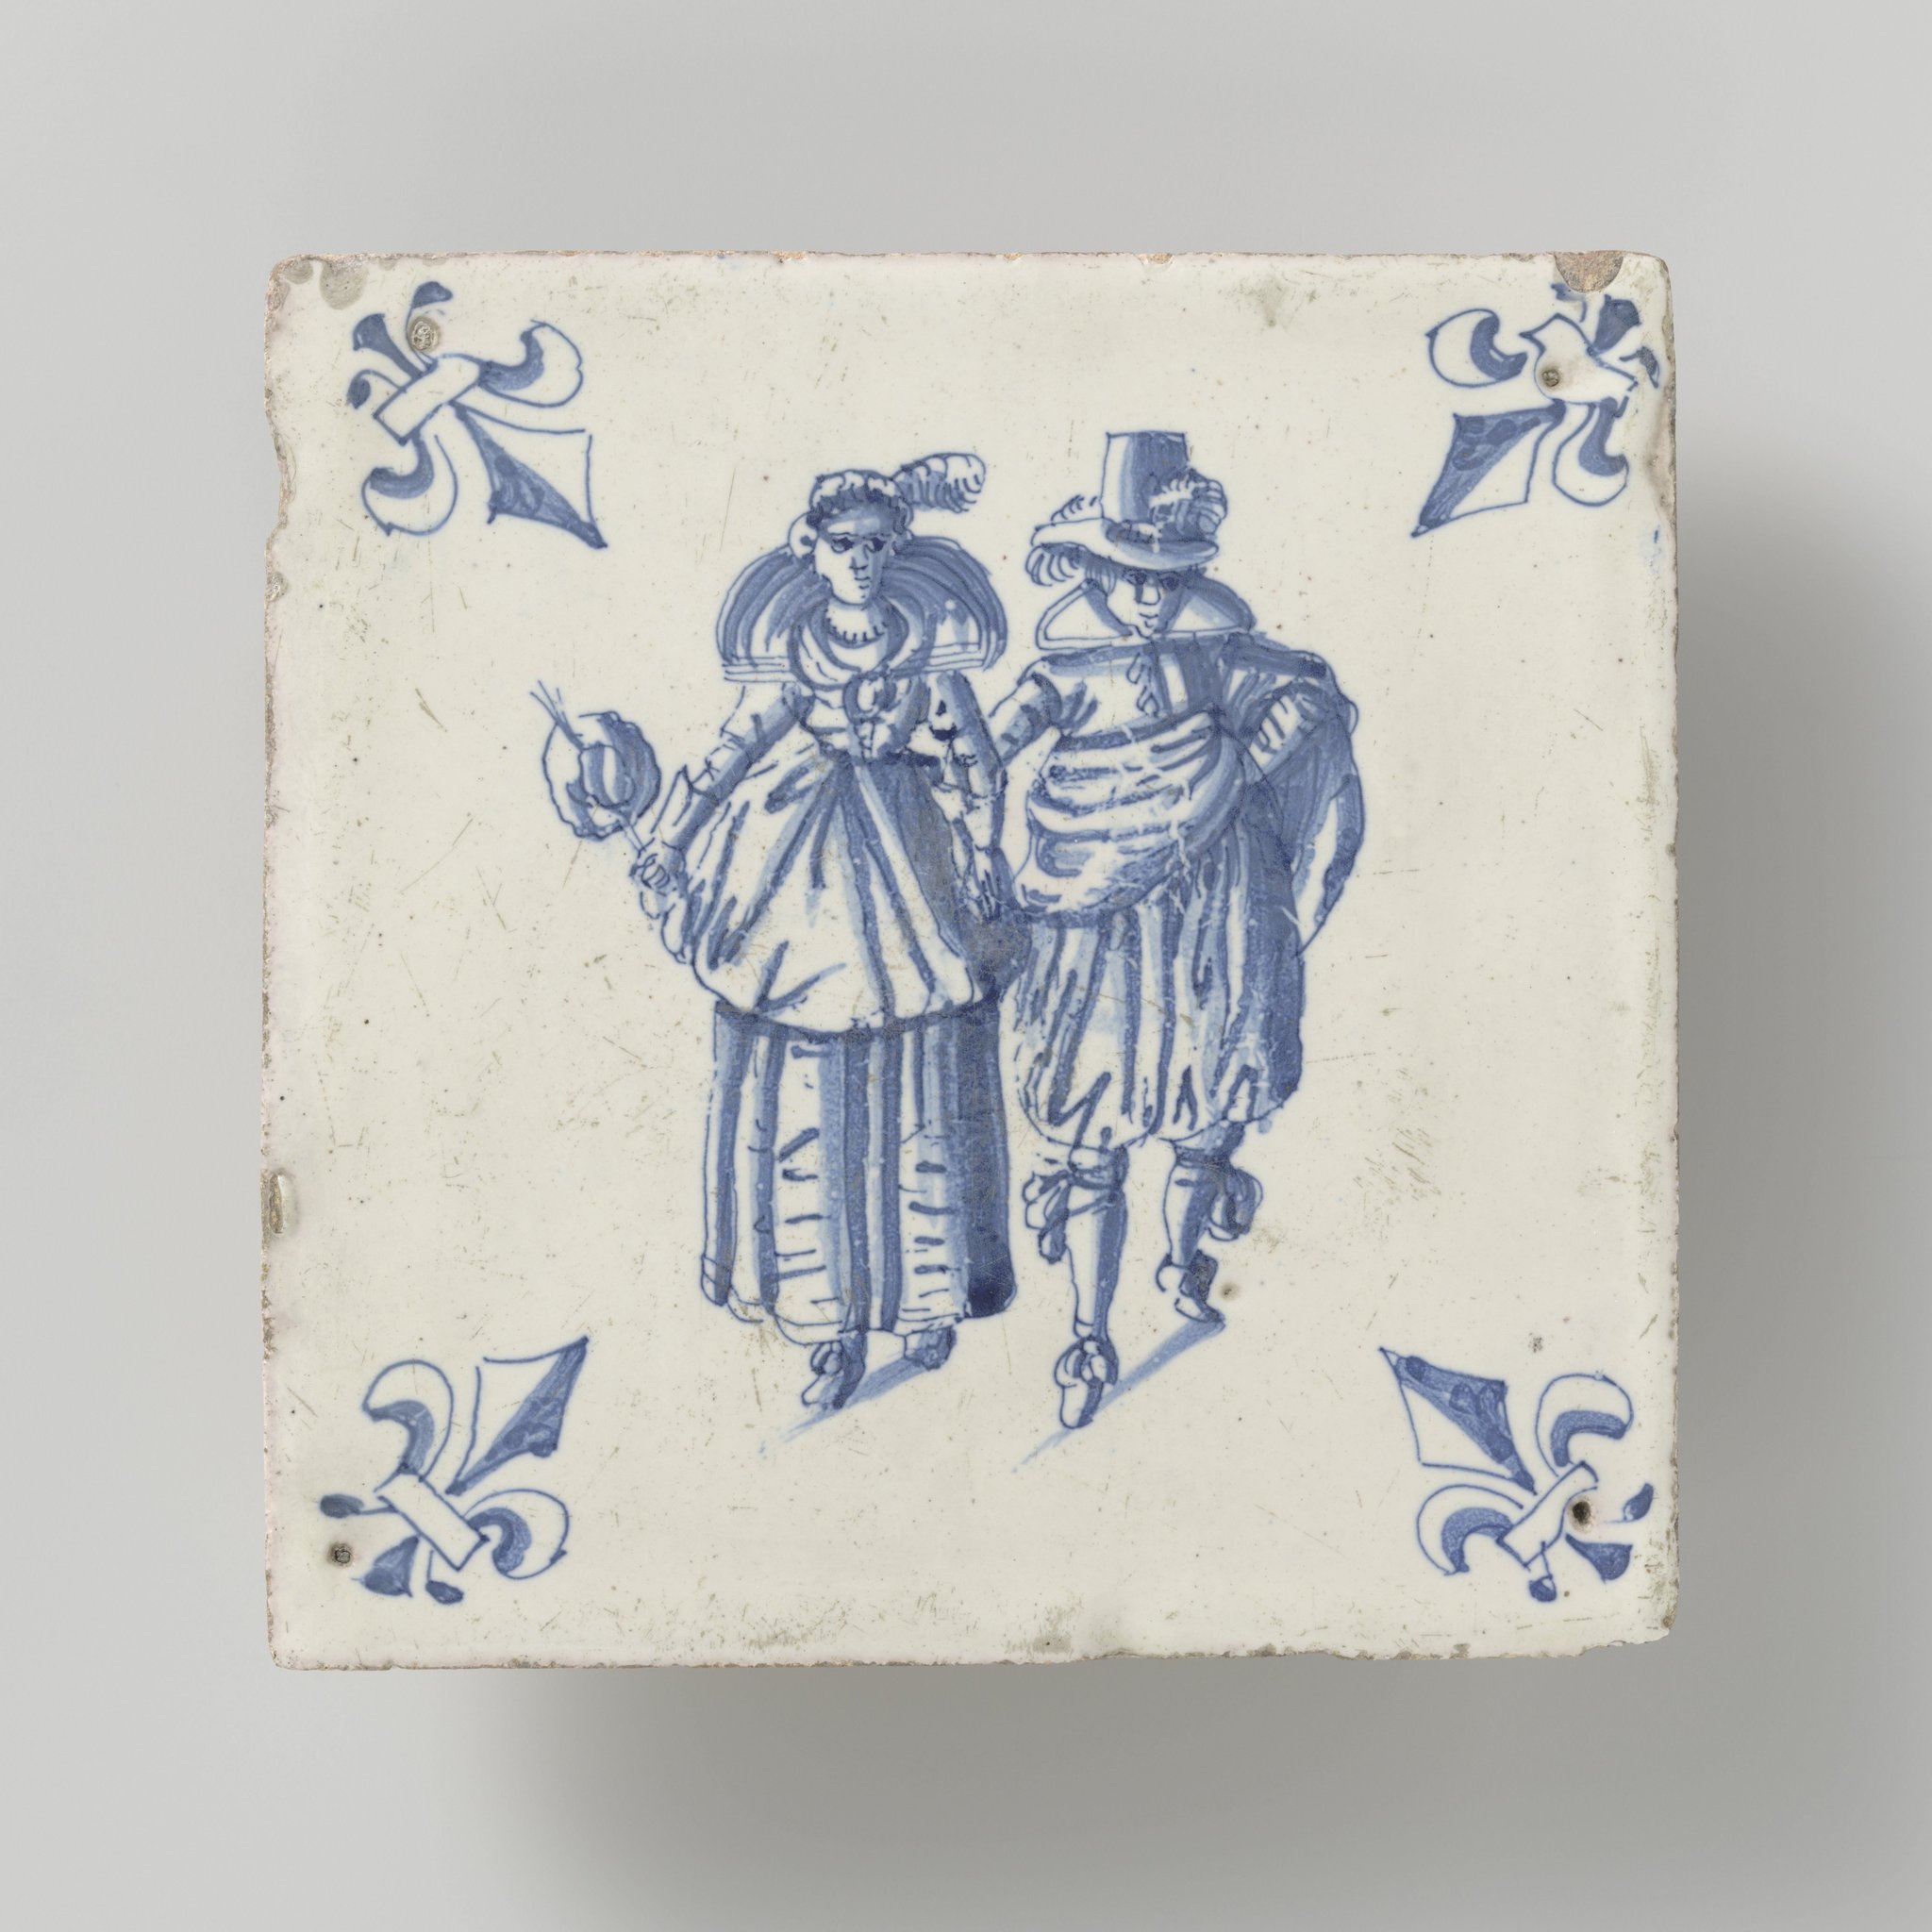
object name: tile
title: Tegel met man en vrouw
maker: Anonymous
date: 1620-1660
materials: earthenware, glaze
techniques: maiolica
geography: netherlands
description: Tegel met een blauw geschilderde man en vrouw staande naast elkaar in 17de eeuws kostuum. In de hoeken, een lelie.